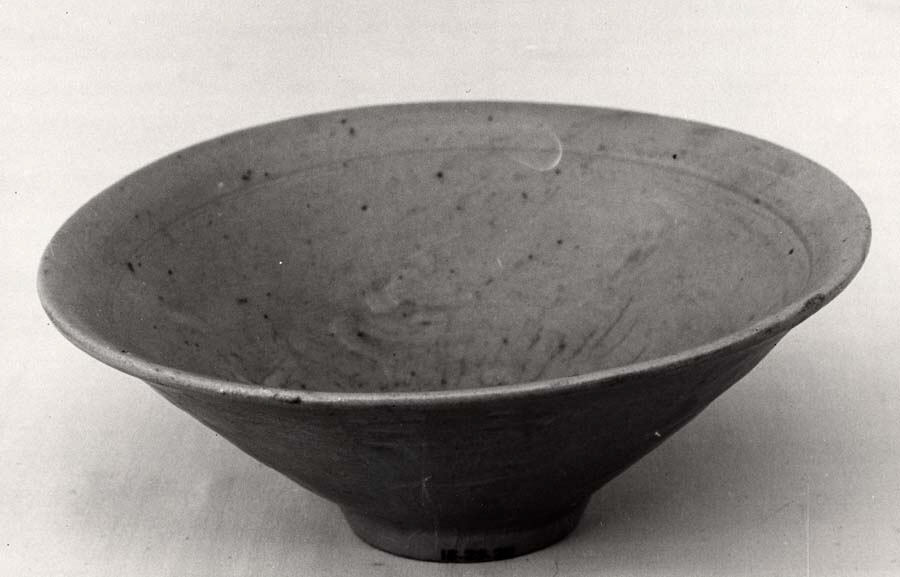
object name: bowl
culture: korean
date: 1101-1133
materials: ceramic glaze, glaze, stoneware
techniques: relief